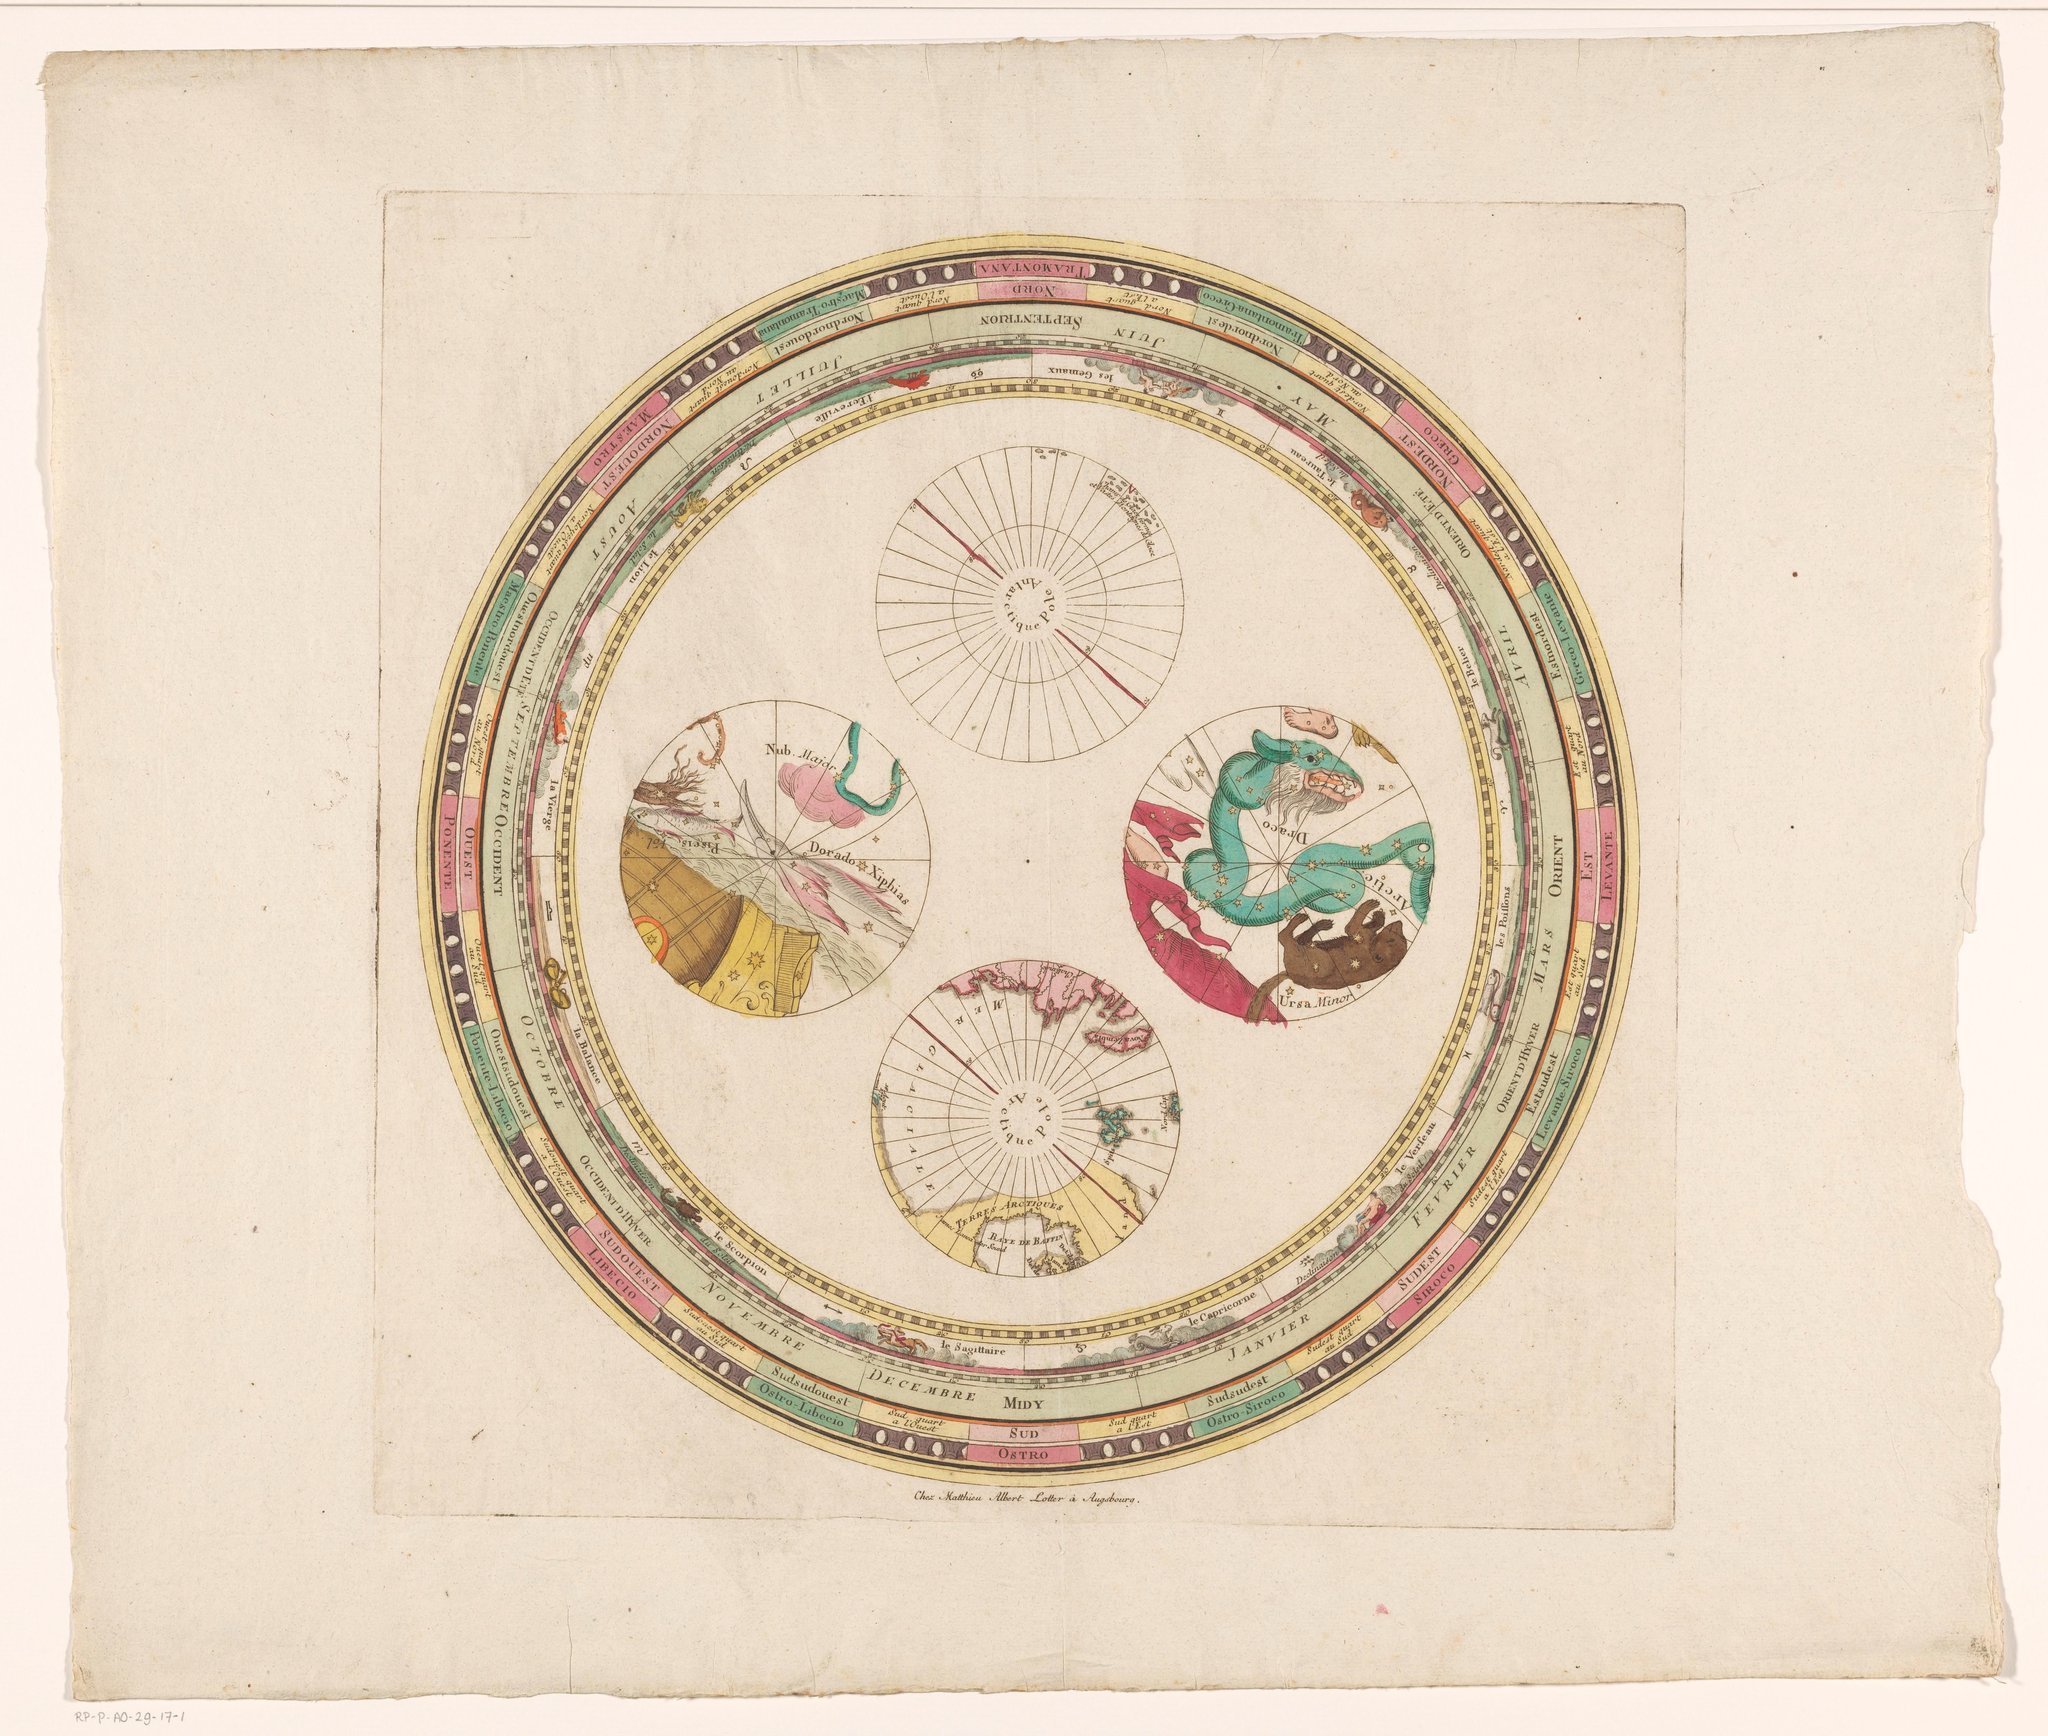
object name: print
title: Globus Coelestis in quo omnes asterismi accurate delineati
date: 1777-1810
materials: paper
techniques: engraving, hand coloring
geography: augsburg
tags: zodiac; the twelve zodiacal signs together, star-globe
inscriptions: collector's mark: Lugt 2228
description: Segmenten bedoeld voor een hemelglobe bestaande uit twaalf segmenten met de hemelen en twee cirkels voor op de polen. Op dit blad ook twee cirkels bedoeld voor een aardglobe.